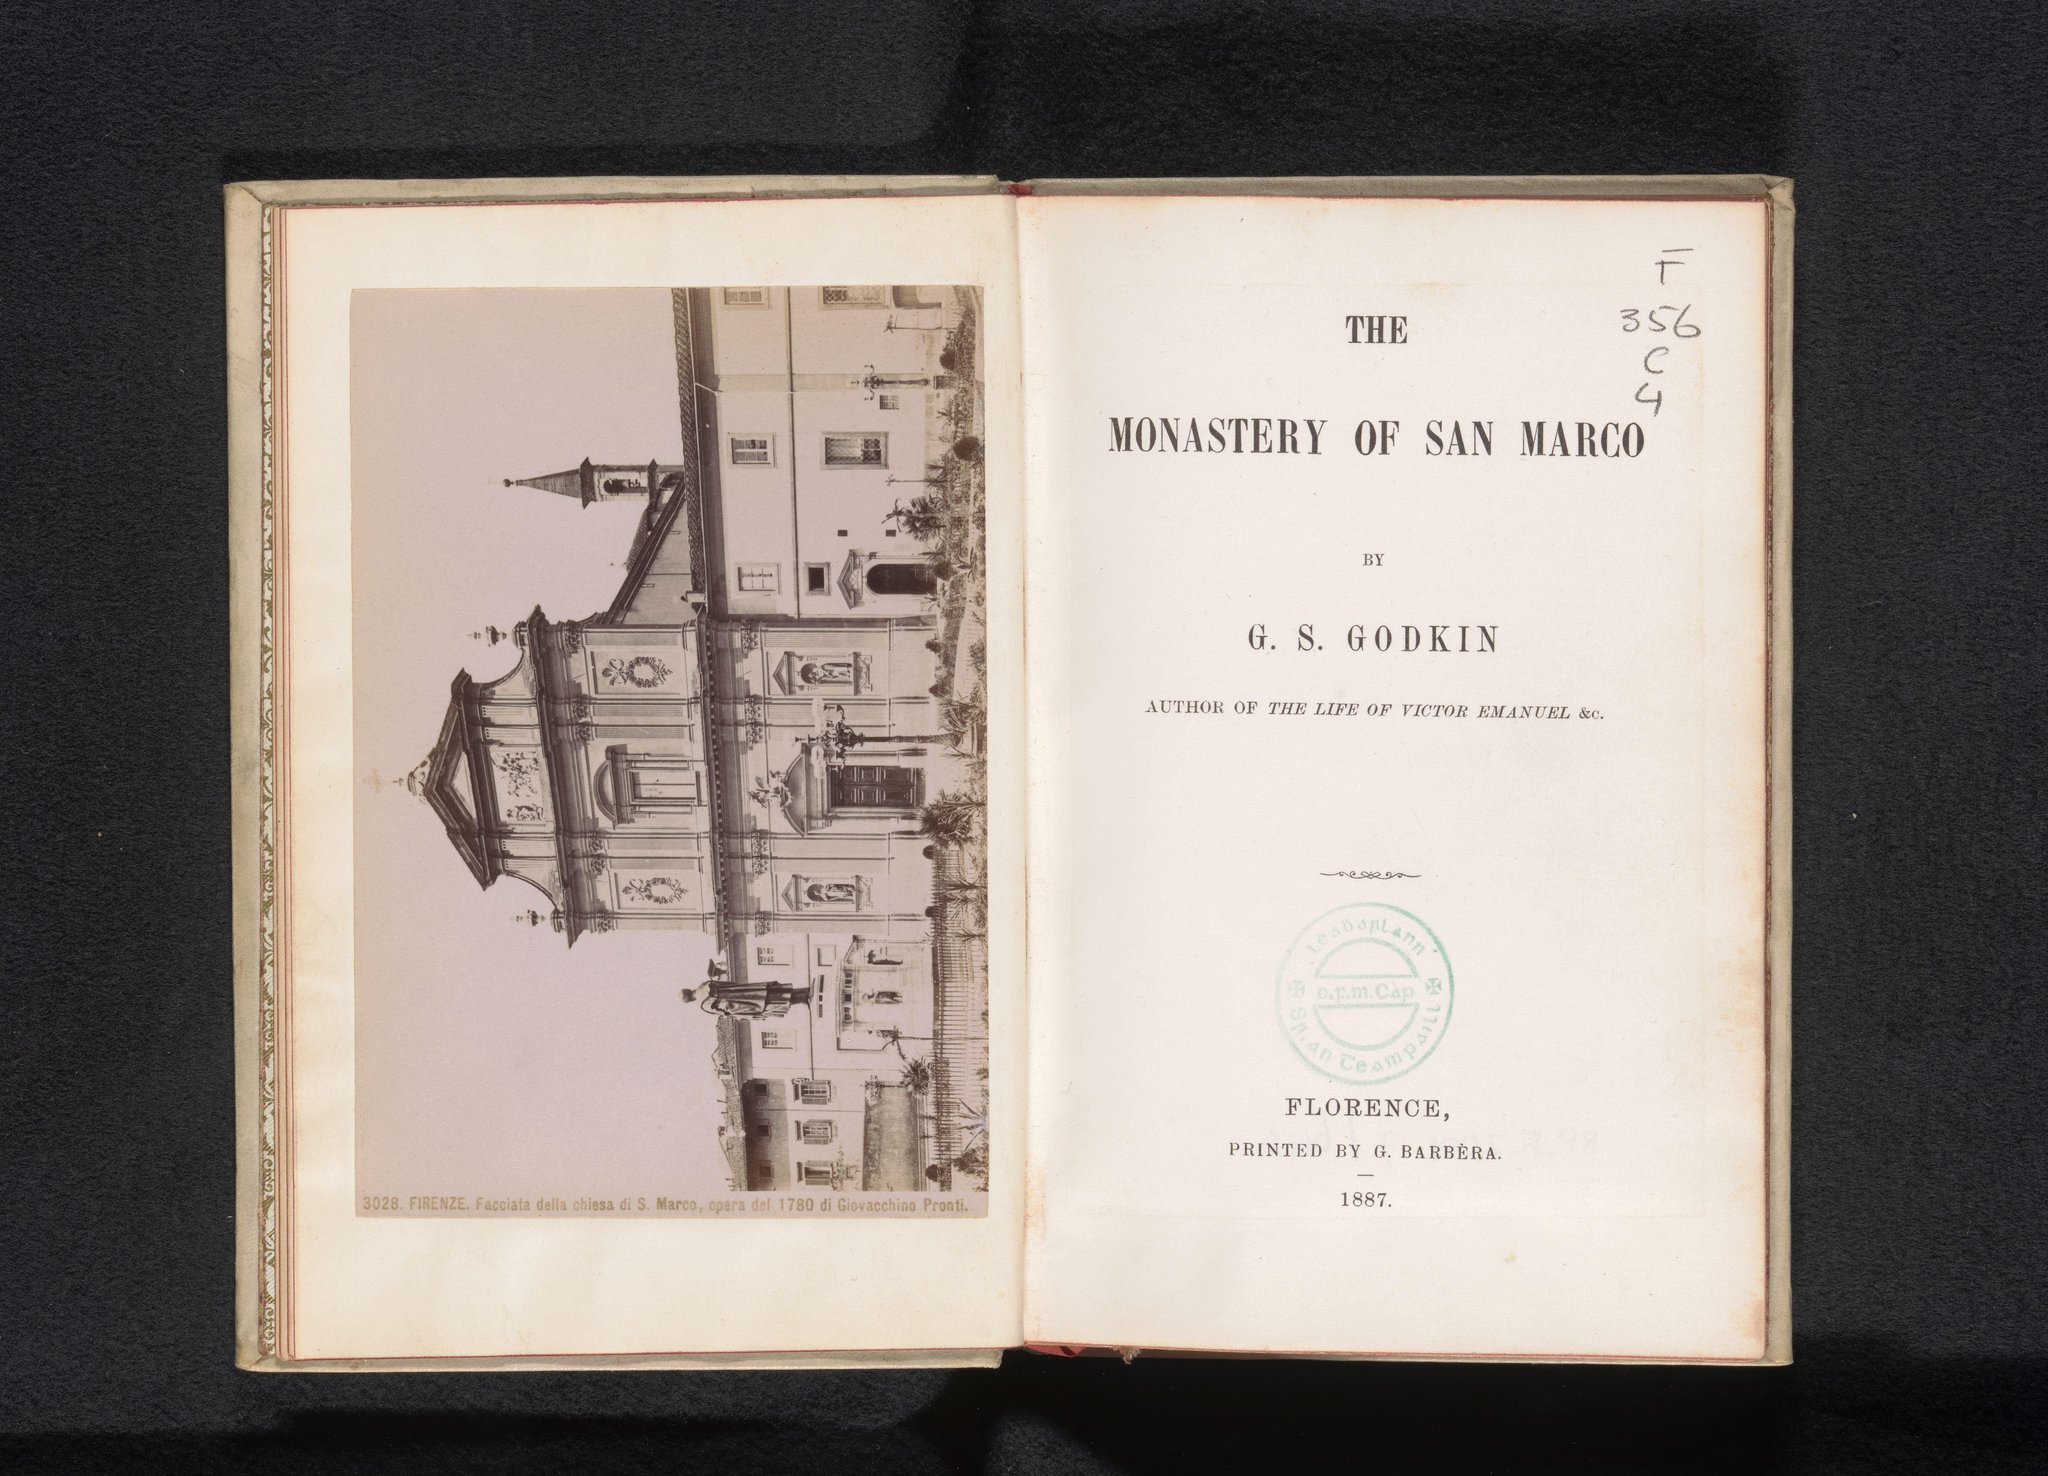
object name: photograph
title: Firenze. Facciata della chiesa di S. Marco, opera del 1780 di Giovacchino Pronti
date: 1877-1887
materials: photographic support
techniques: albumen print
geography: florence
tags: façade (of house or building)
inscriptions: number: ‘3028.’